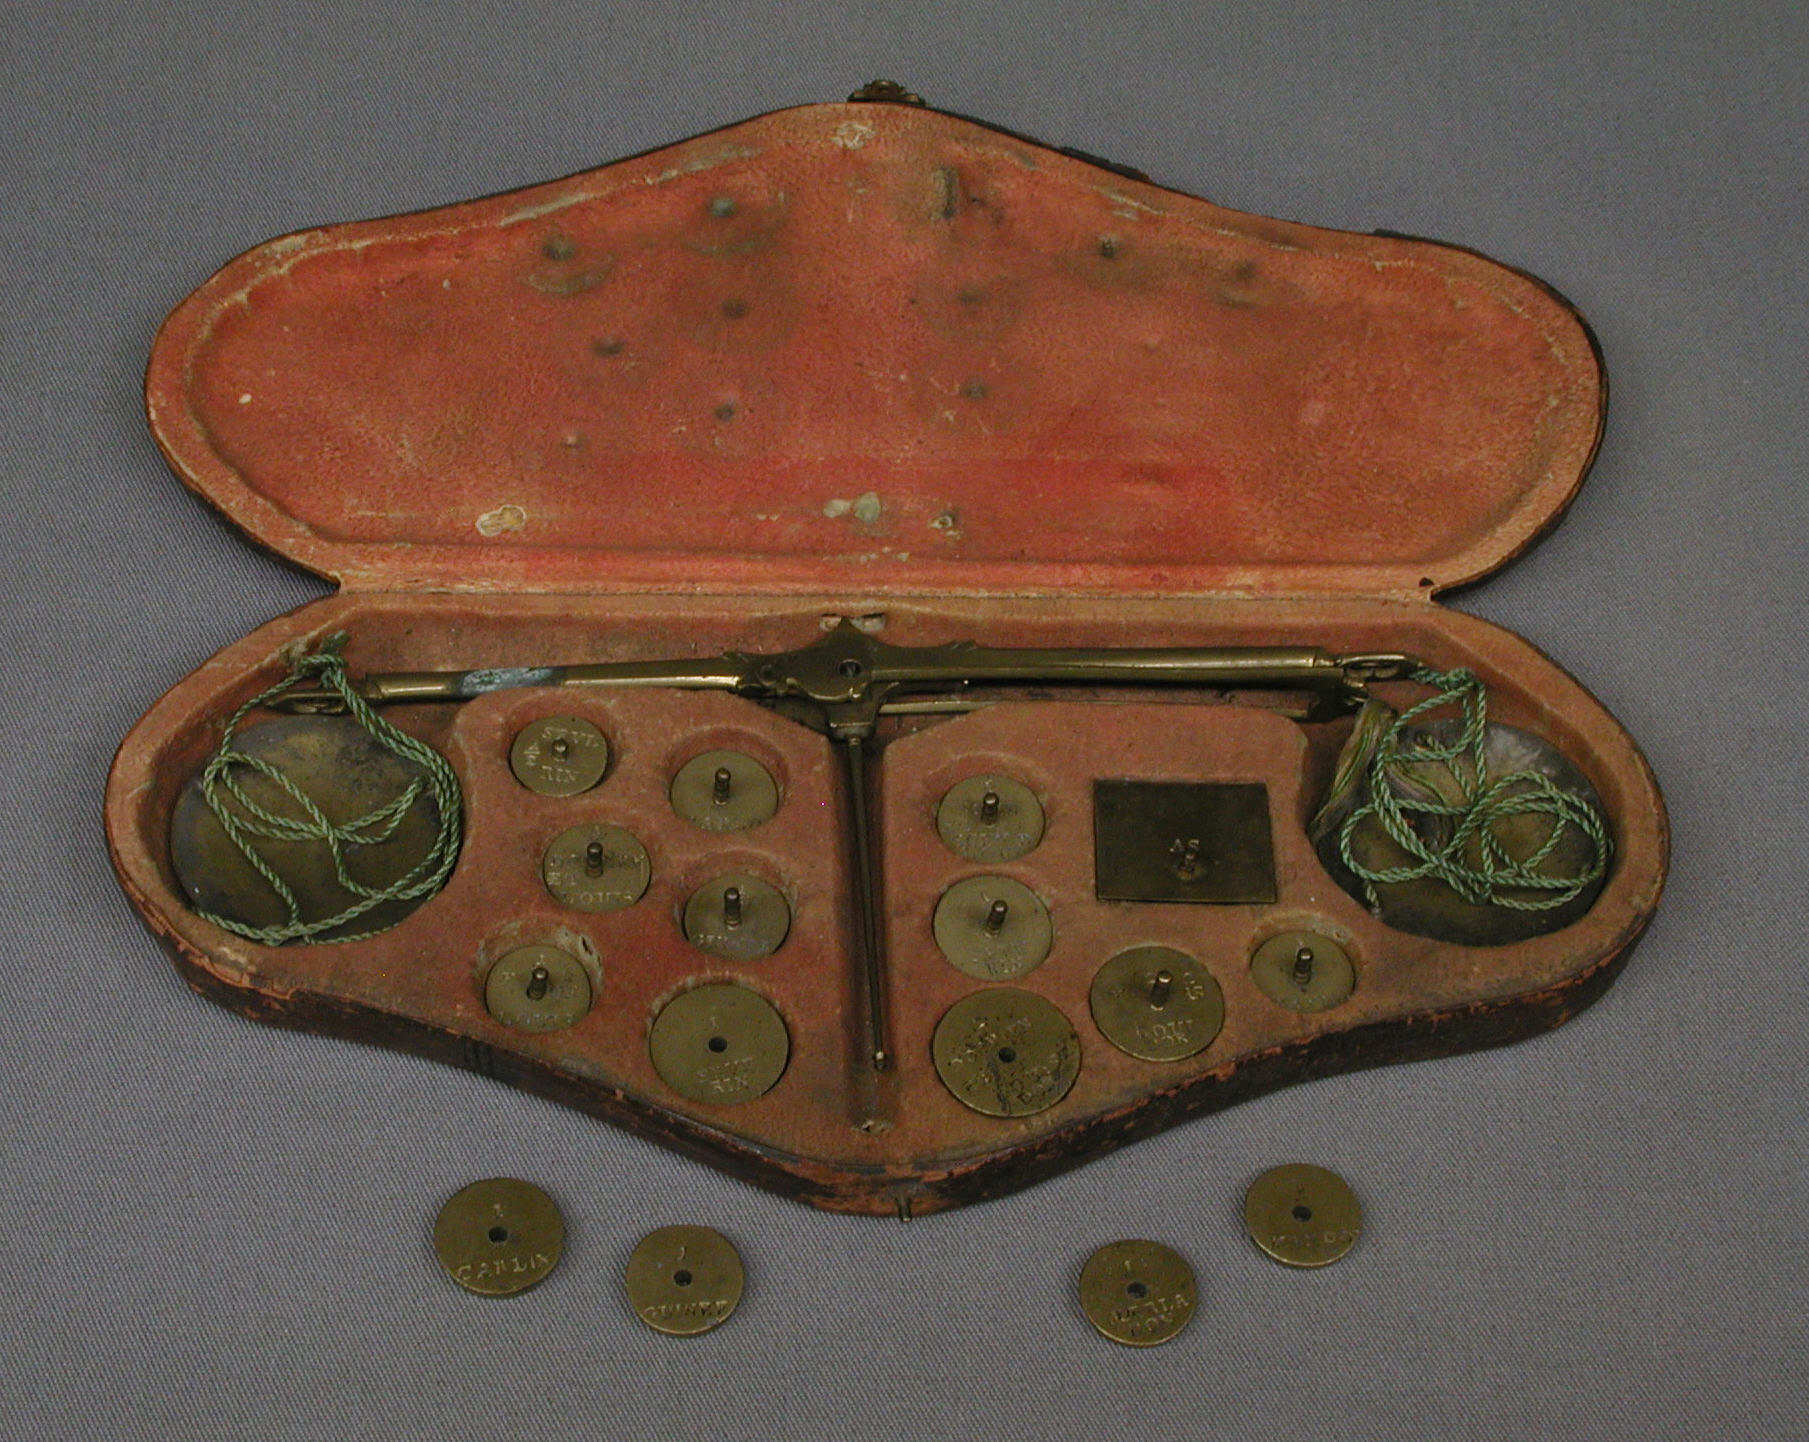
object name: balance and weight with case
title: Balance and weights with case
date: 1667-1733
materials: brass, cord, leather, linen, steel, wood